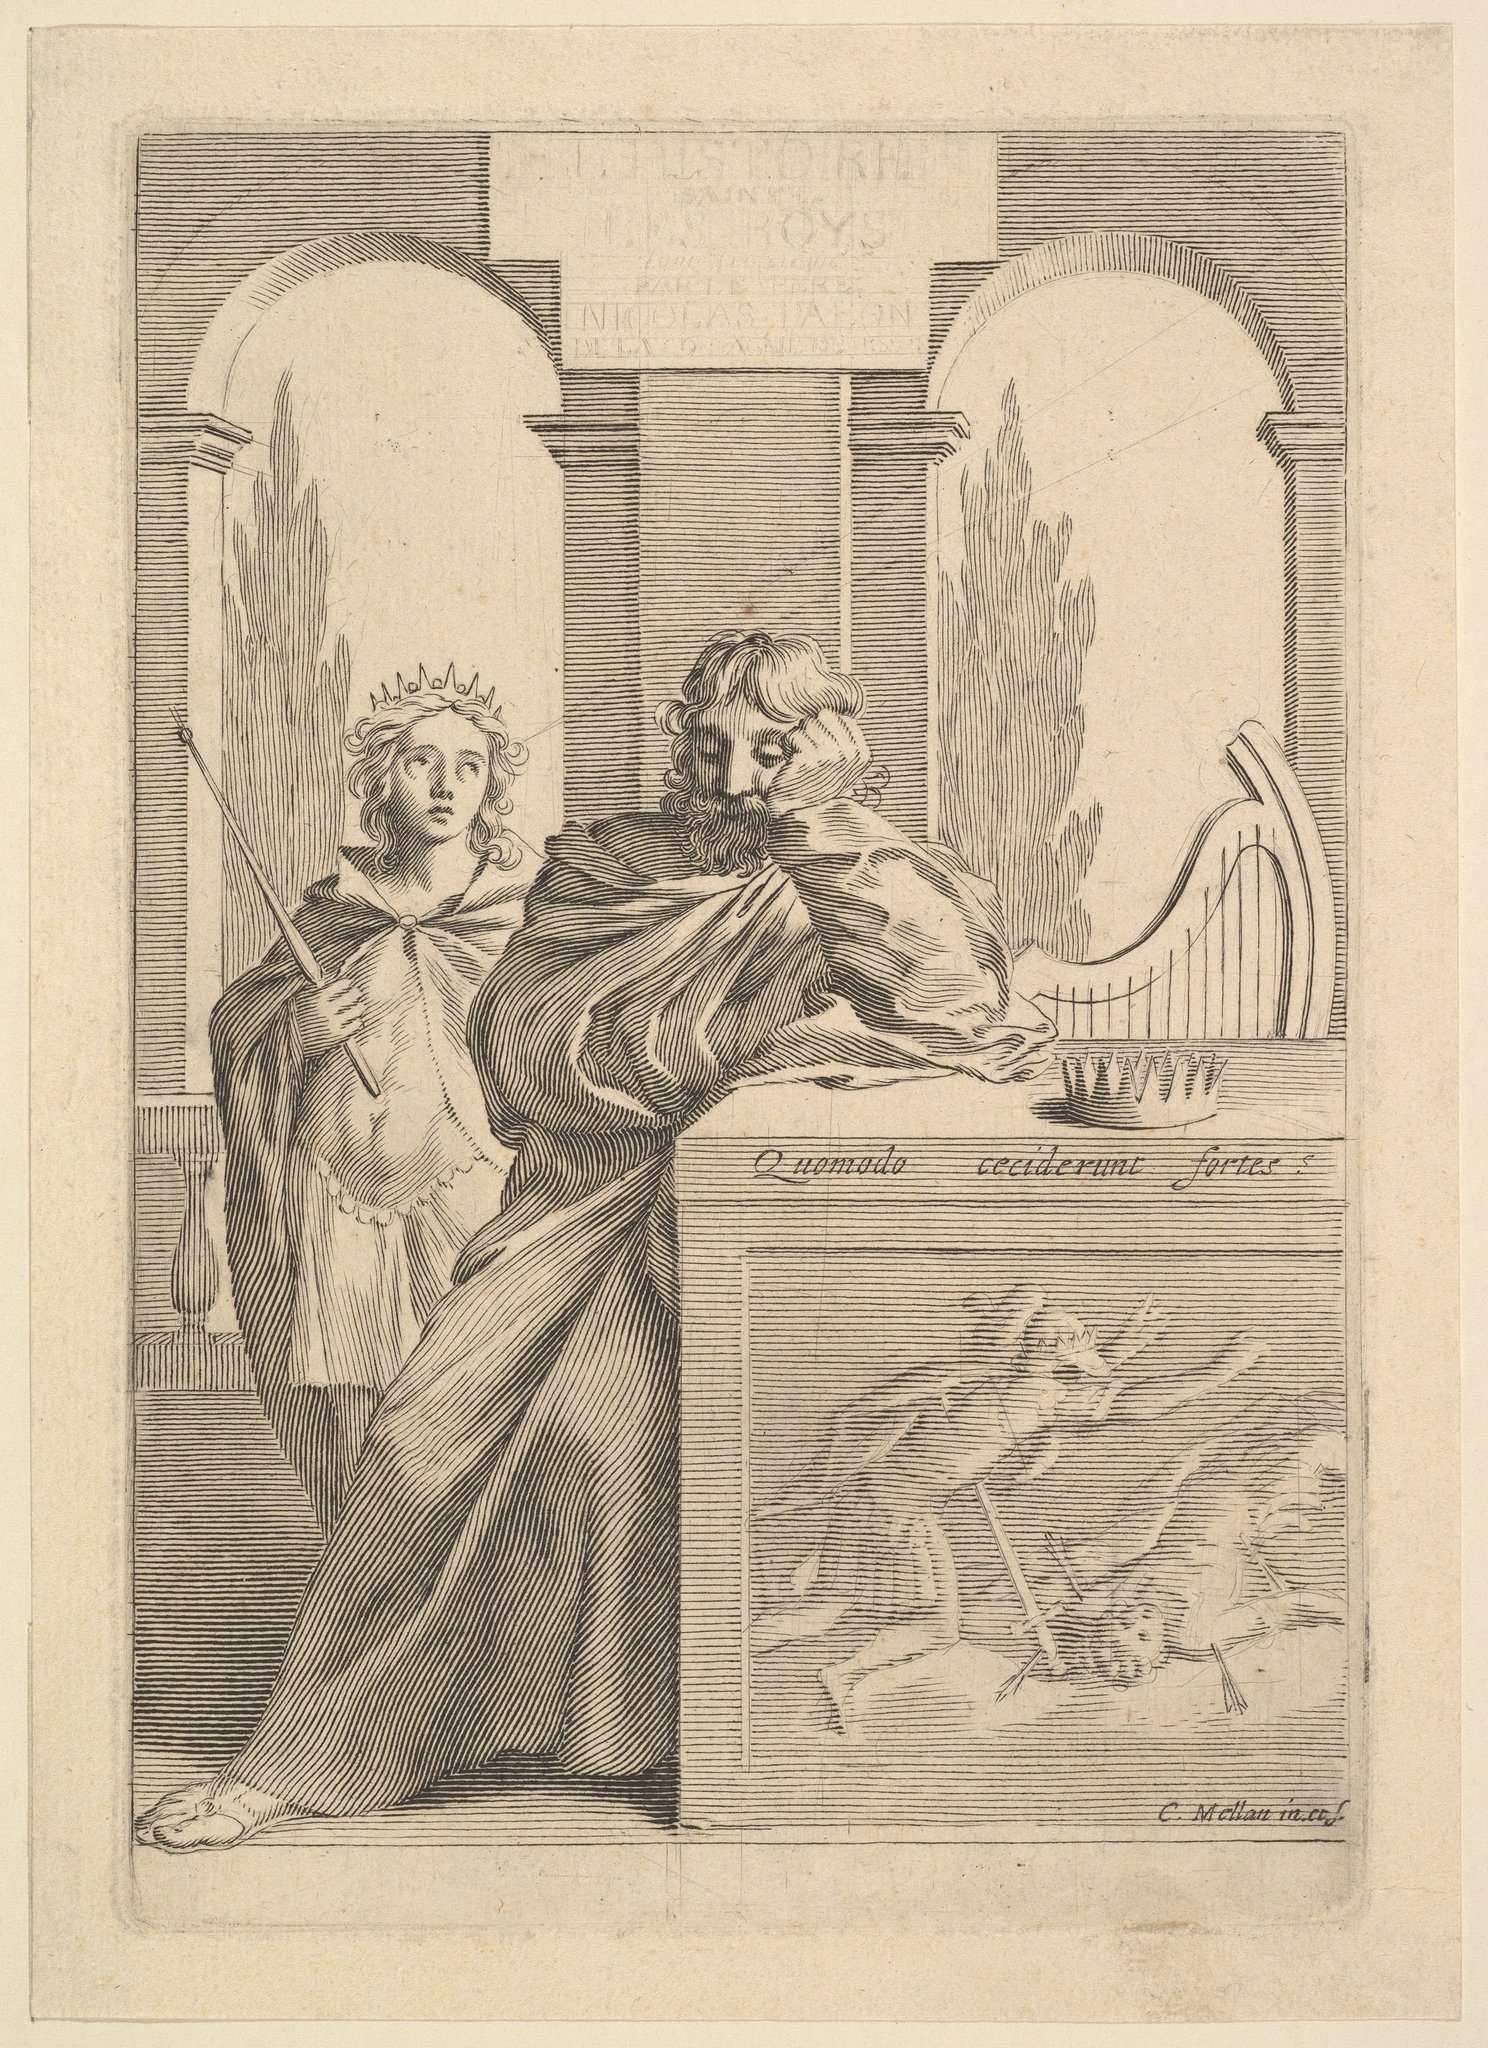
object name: print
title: David: Title Page for Talon, L'Histoire sainte, III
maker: claude mellan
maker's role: artist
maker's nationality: french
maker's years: 1598-1688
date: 1645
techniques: engraving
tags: men,david